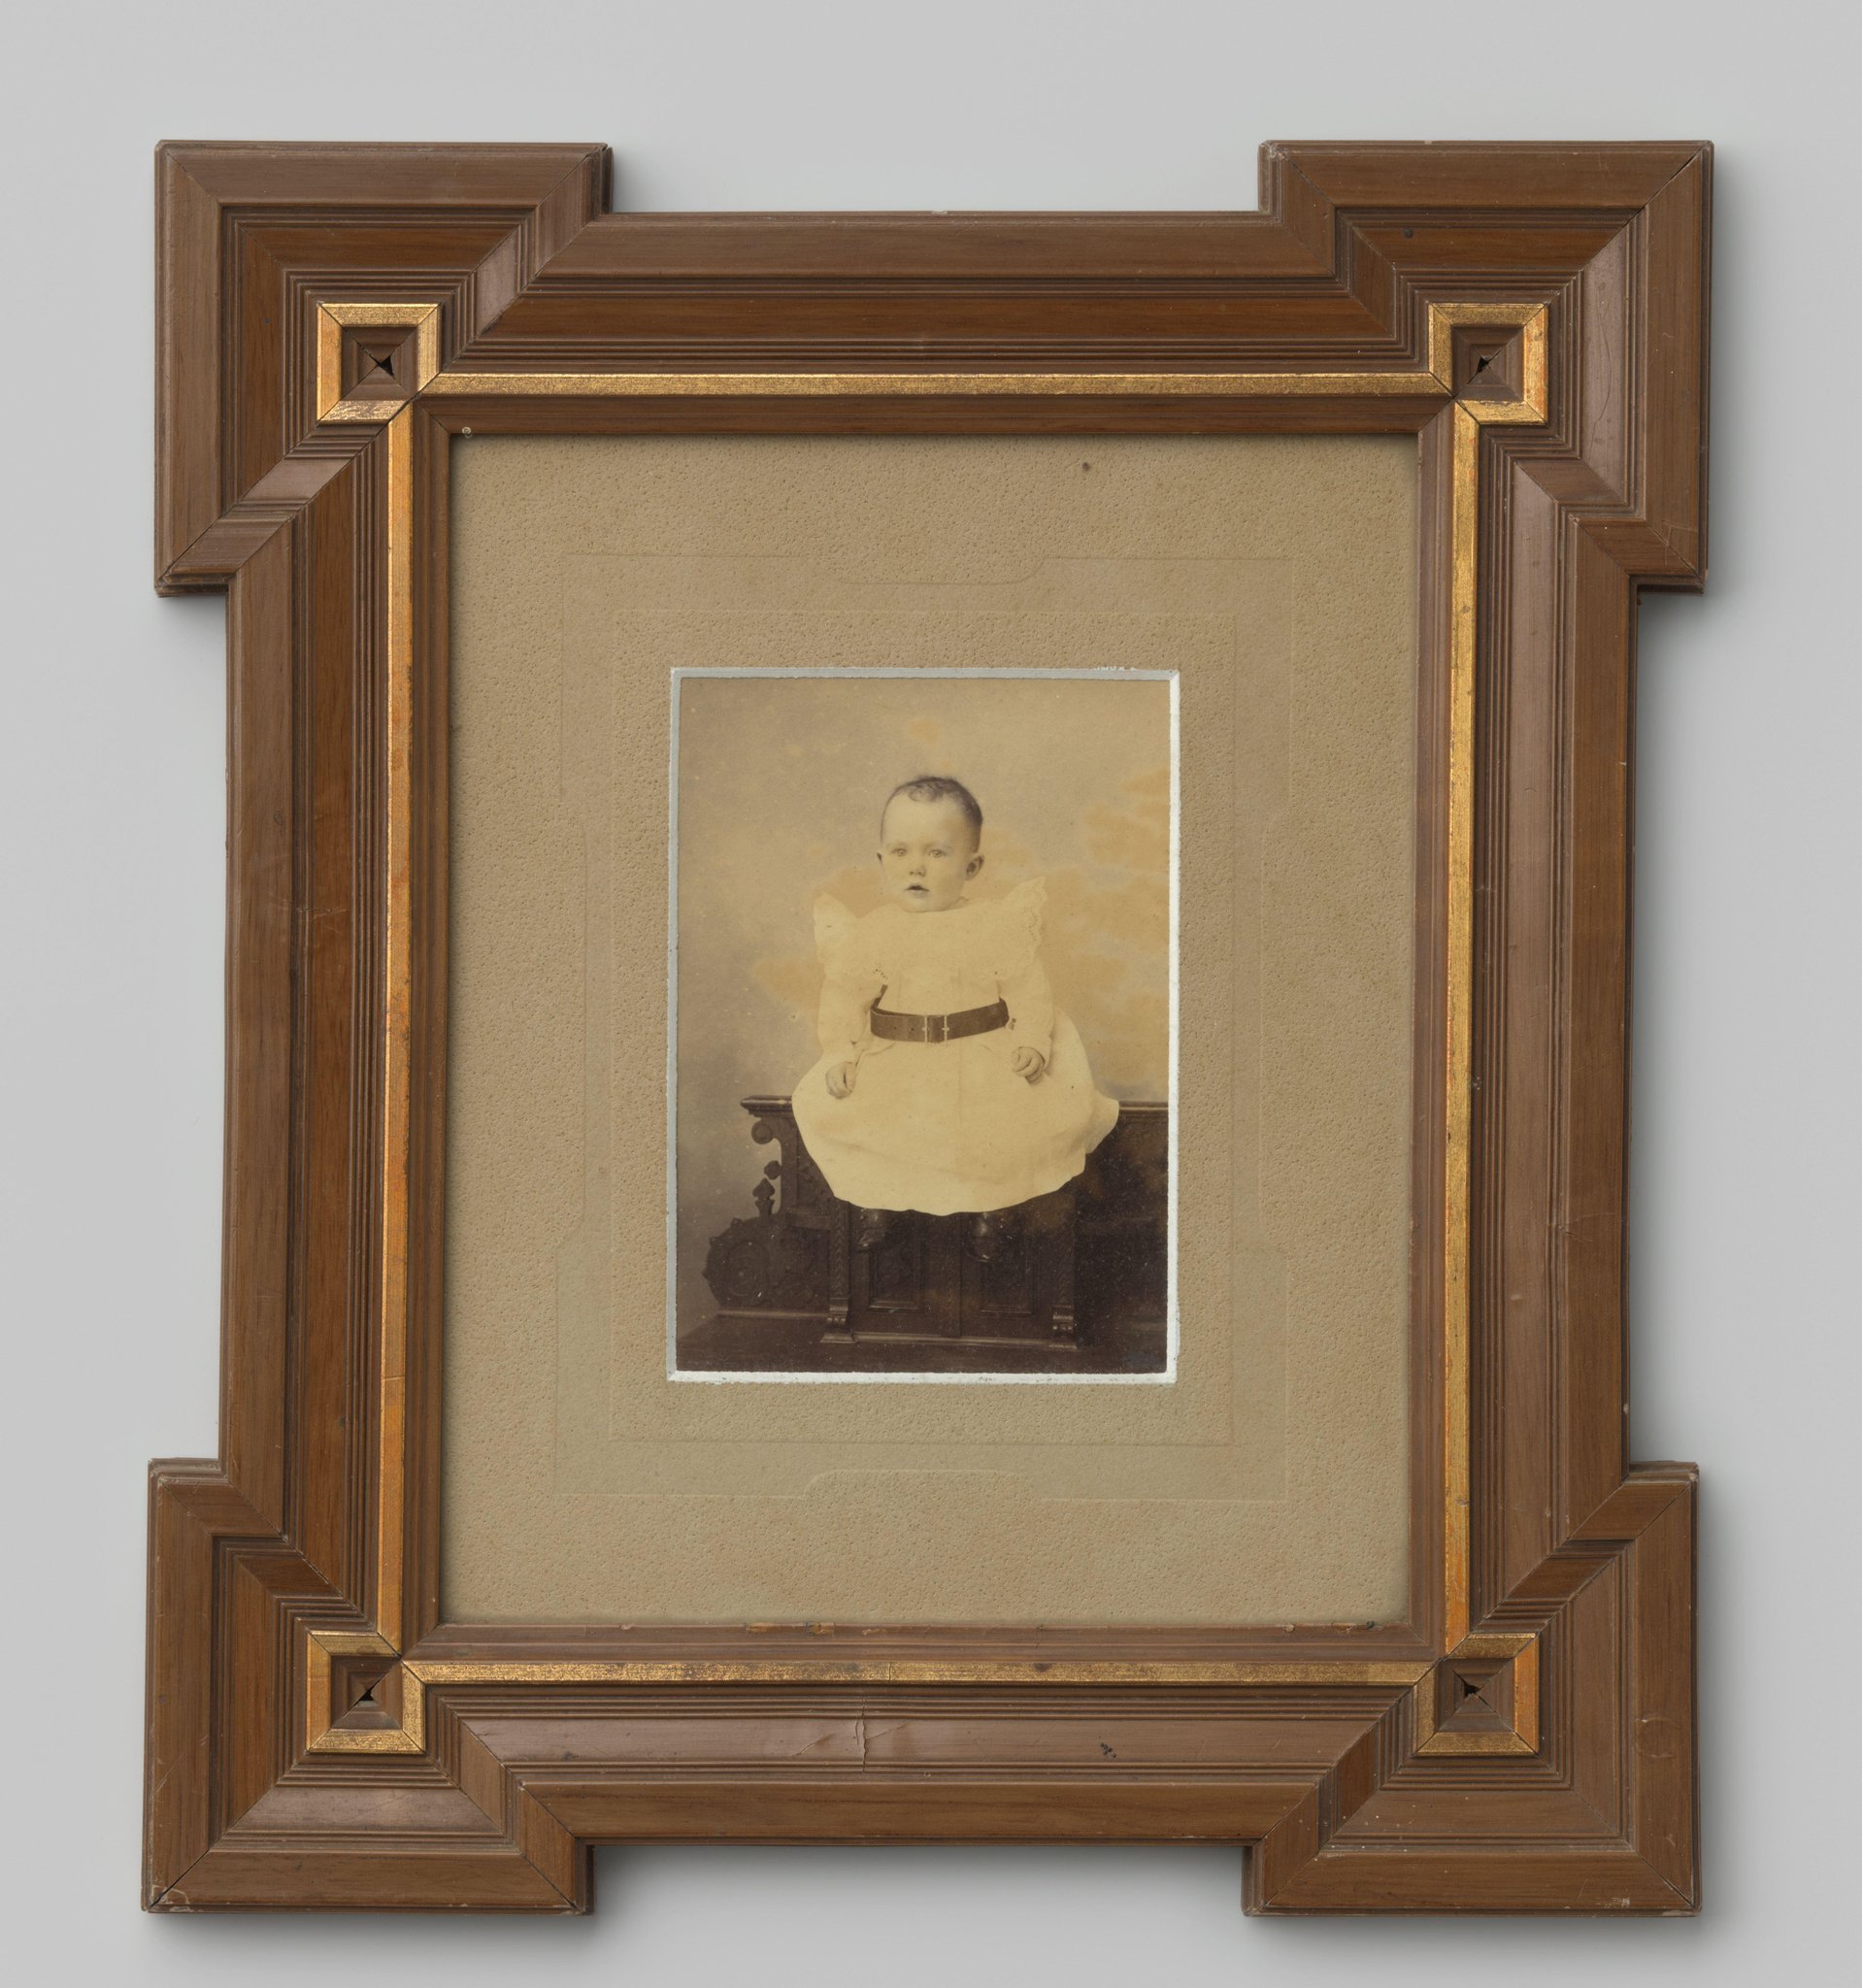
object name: photograph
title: Portret van Cornelis Rooker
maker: Anonymous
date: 1905-1908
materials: cardboard, glass, metal, paper, wood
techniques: albumen print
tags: toddler, historical persons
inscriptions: inscription: ‘Cornelis Rooker/ geb. 4-4-1904’